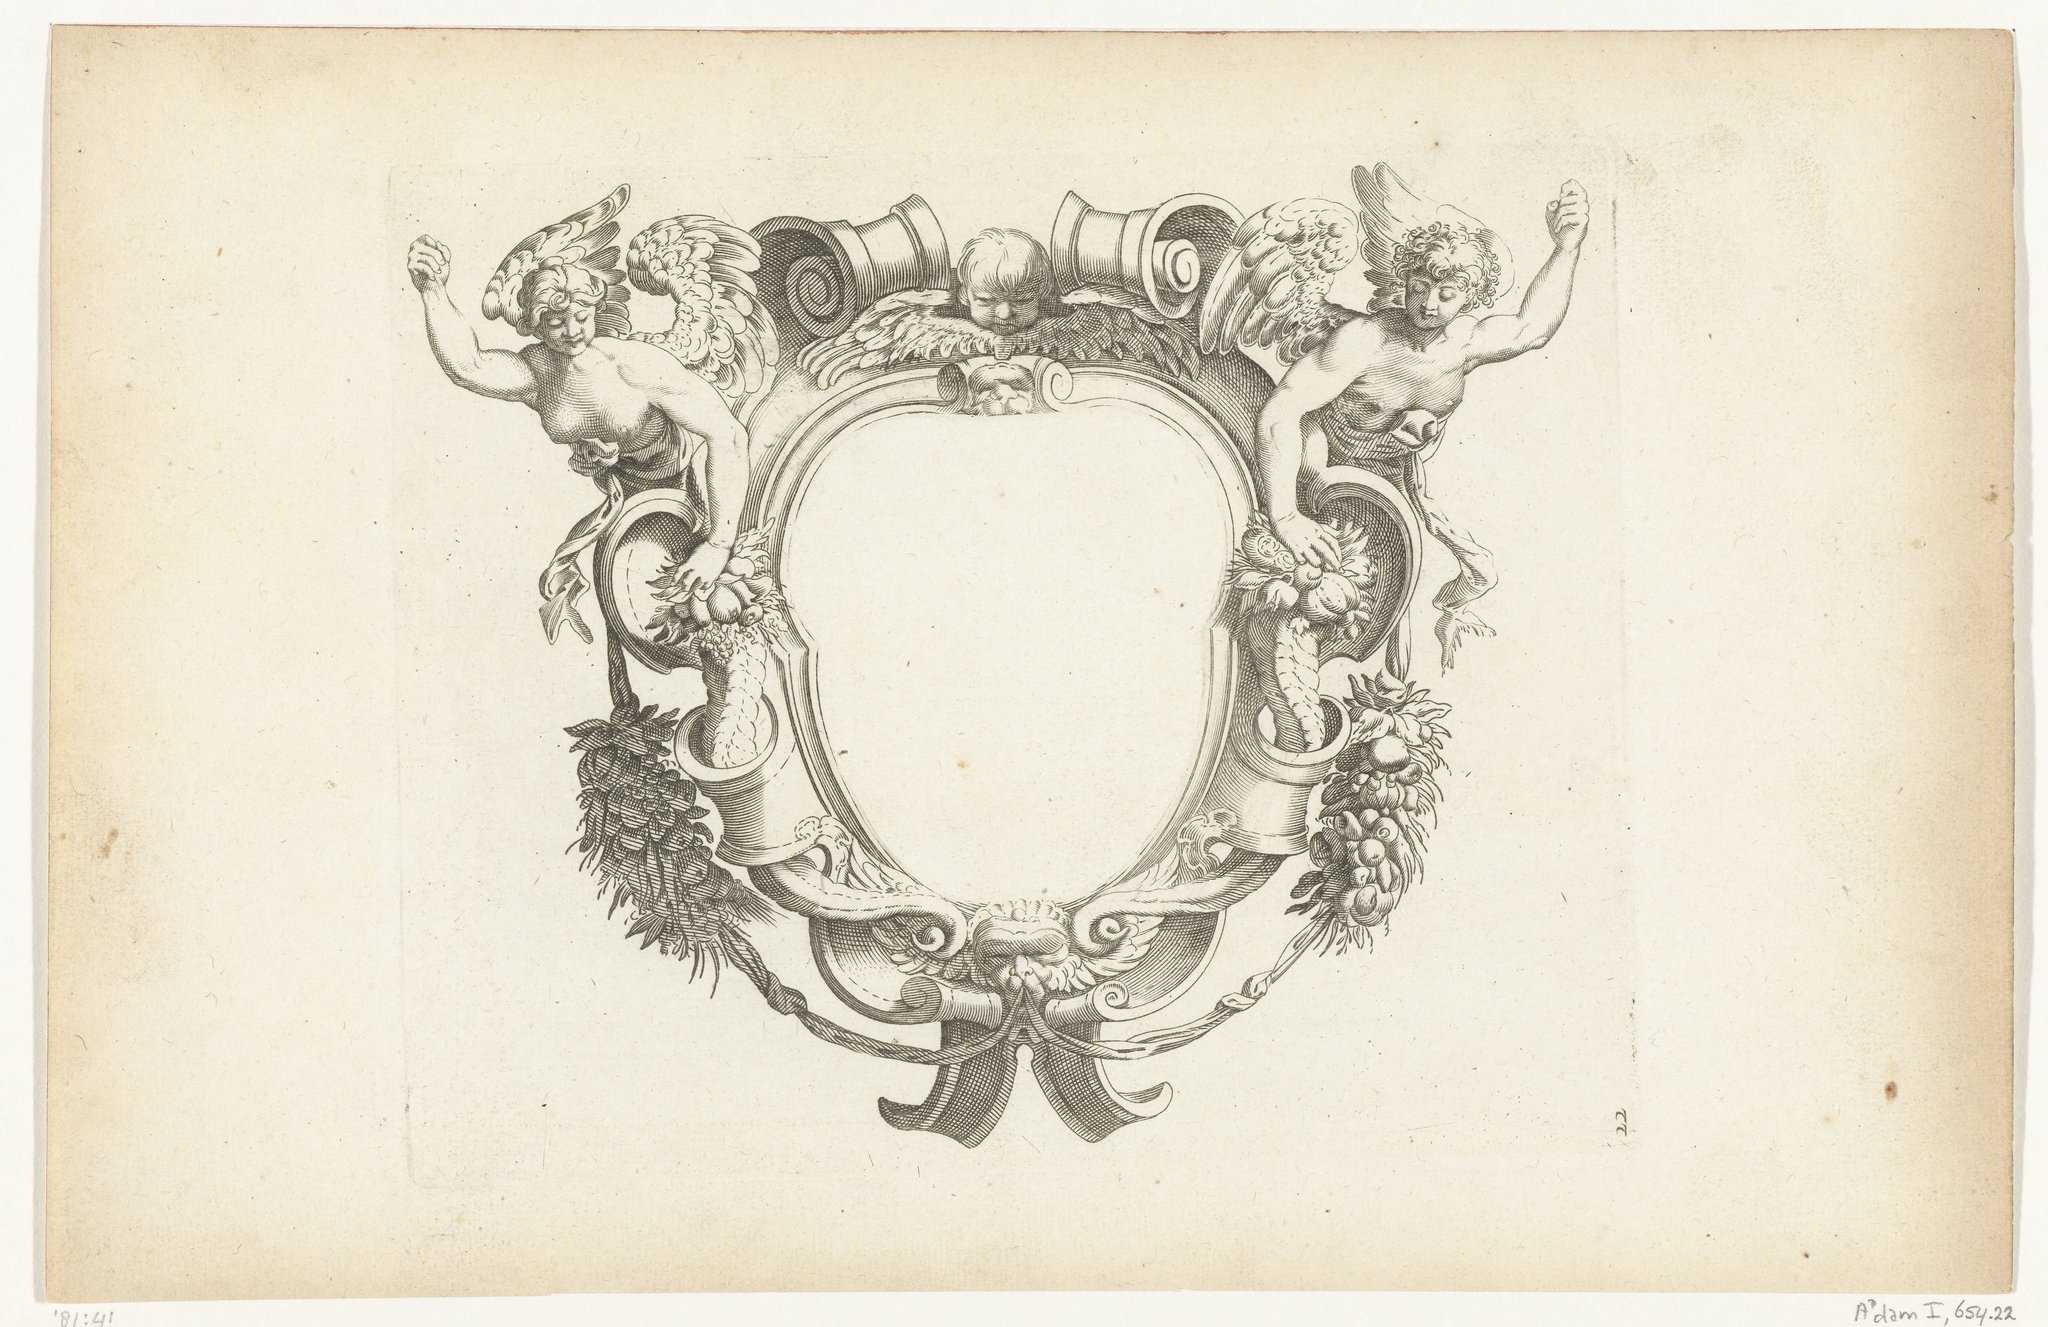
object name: print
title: Cartouche met twee bovenlichamen van gevleugelde vrouwen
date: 1613-1657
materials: paper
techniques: engraving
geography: france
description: Beide vrouwen hebben een hand in de lucht geheven terwijl de andere rust op een hoorn des overvloeds.